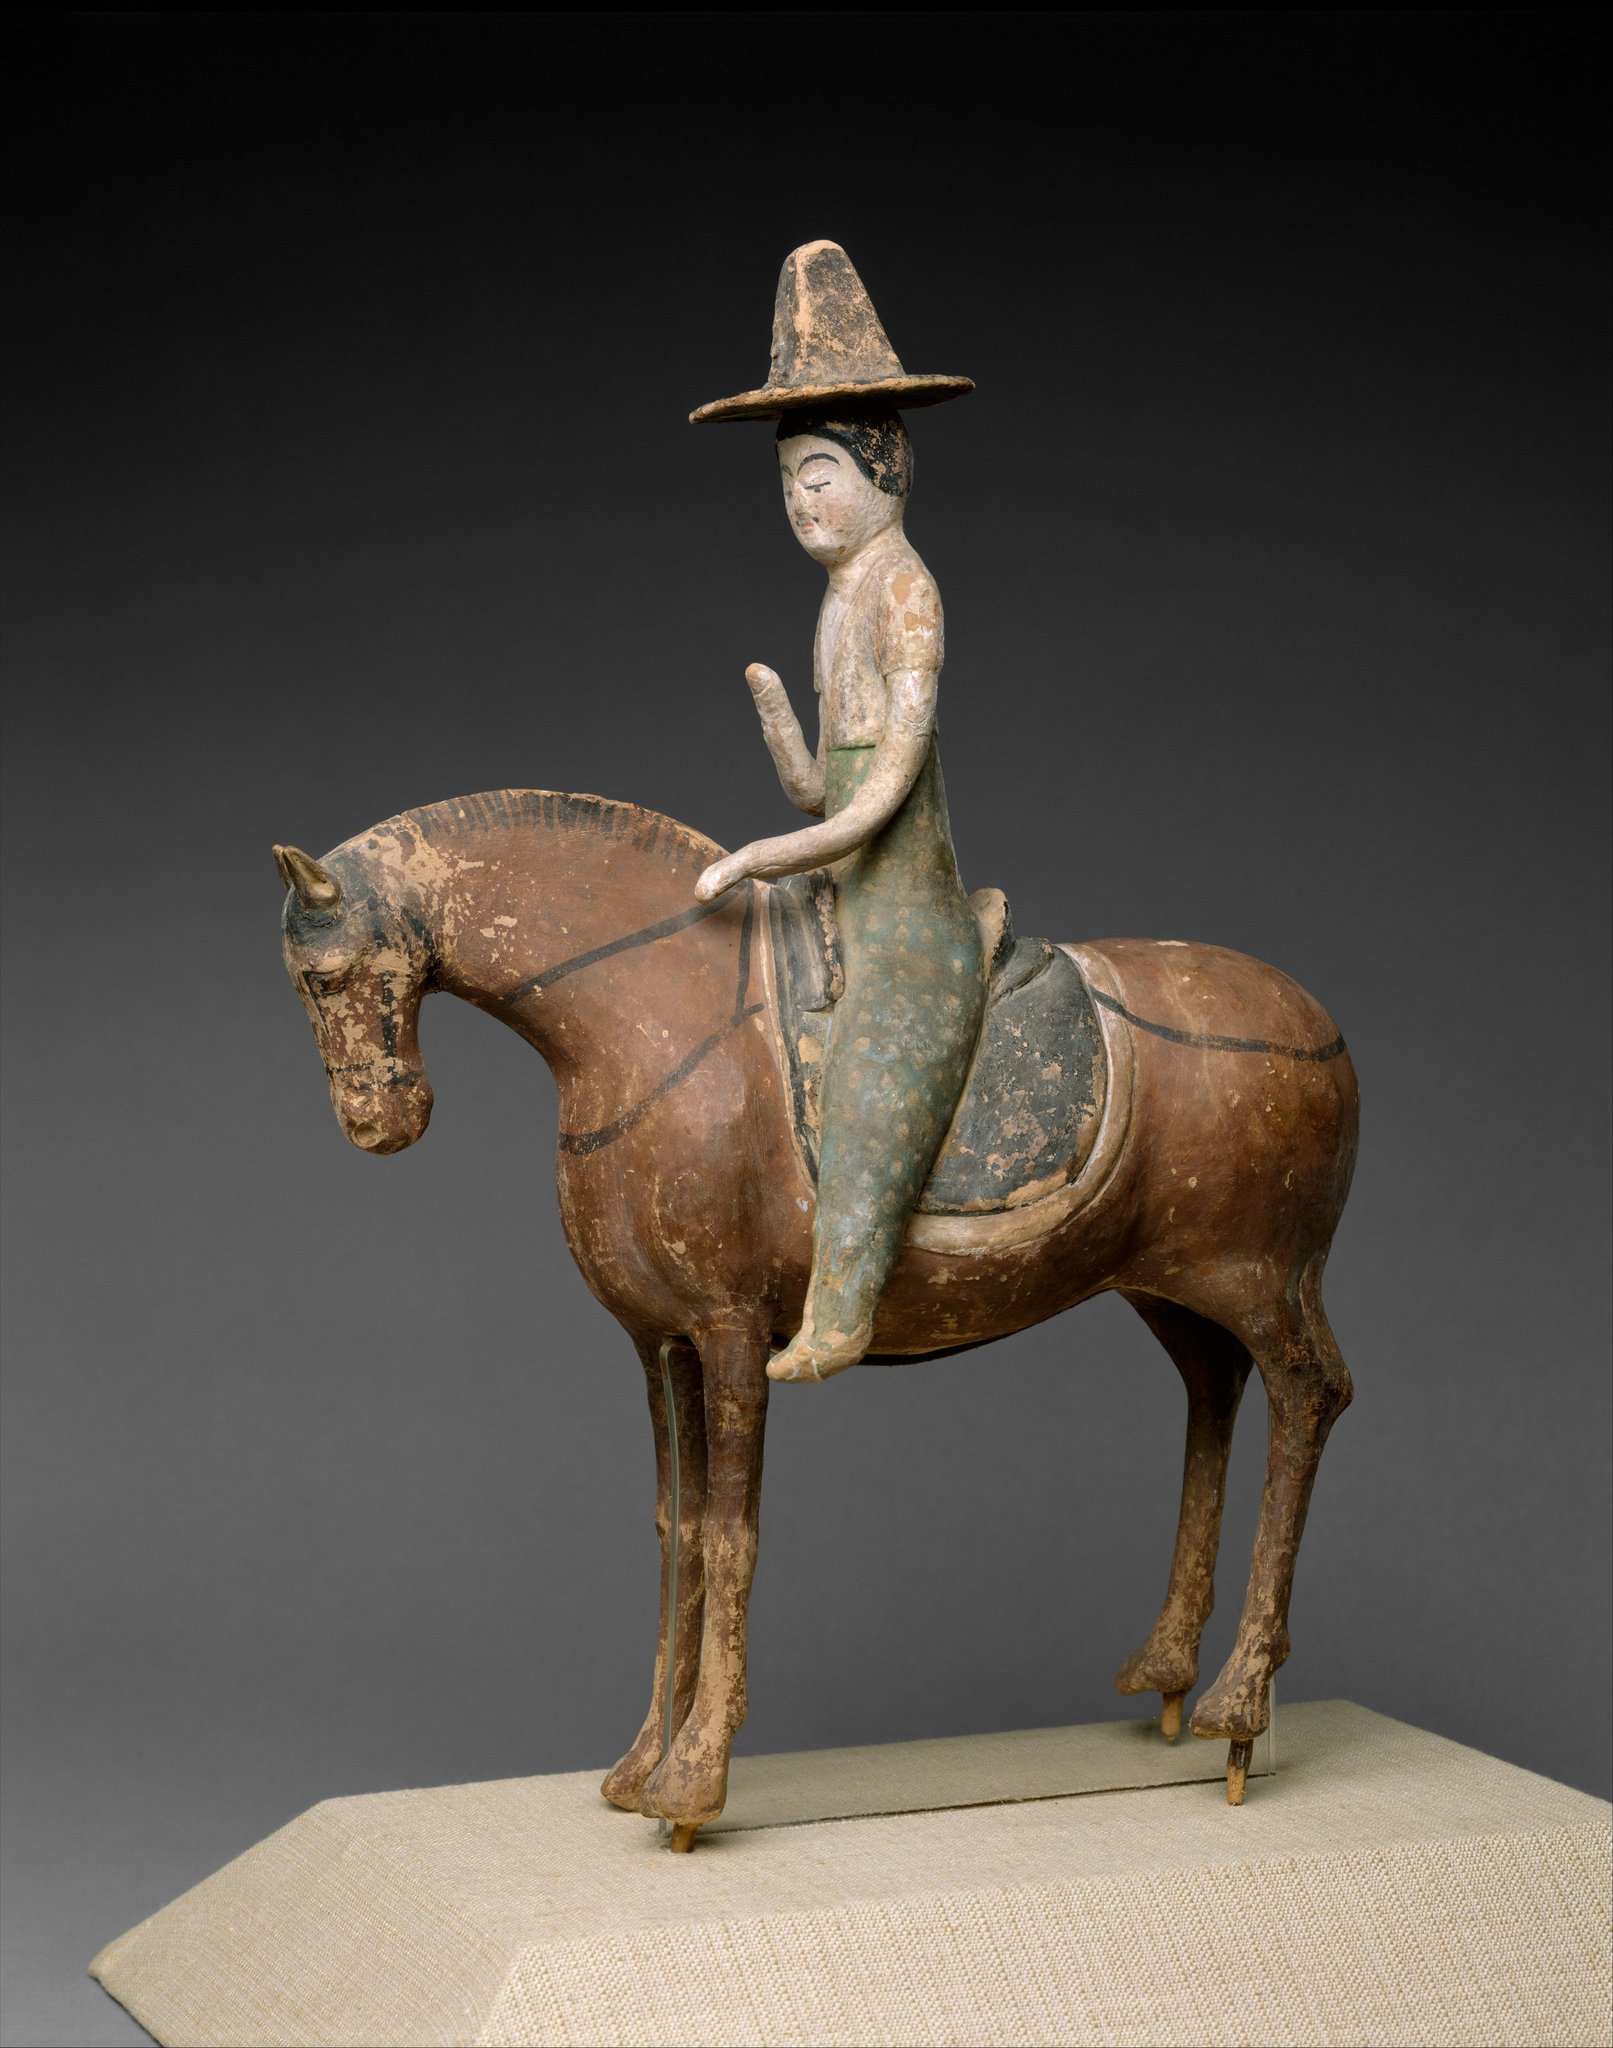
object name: figure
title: Horse and female rider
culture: chinese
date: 601-700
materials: clay, pigment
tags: women,horses